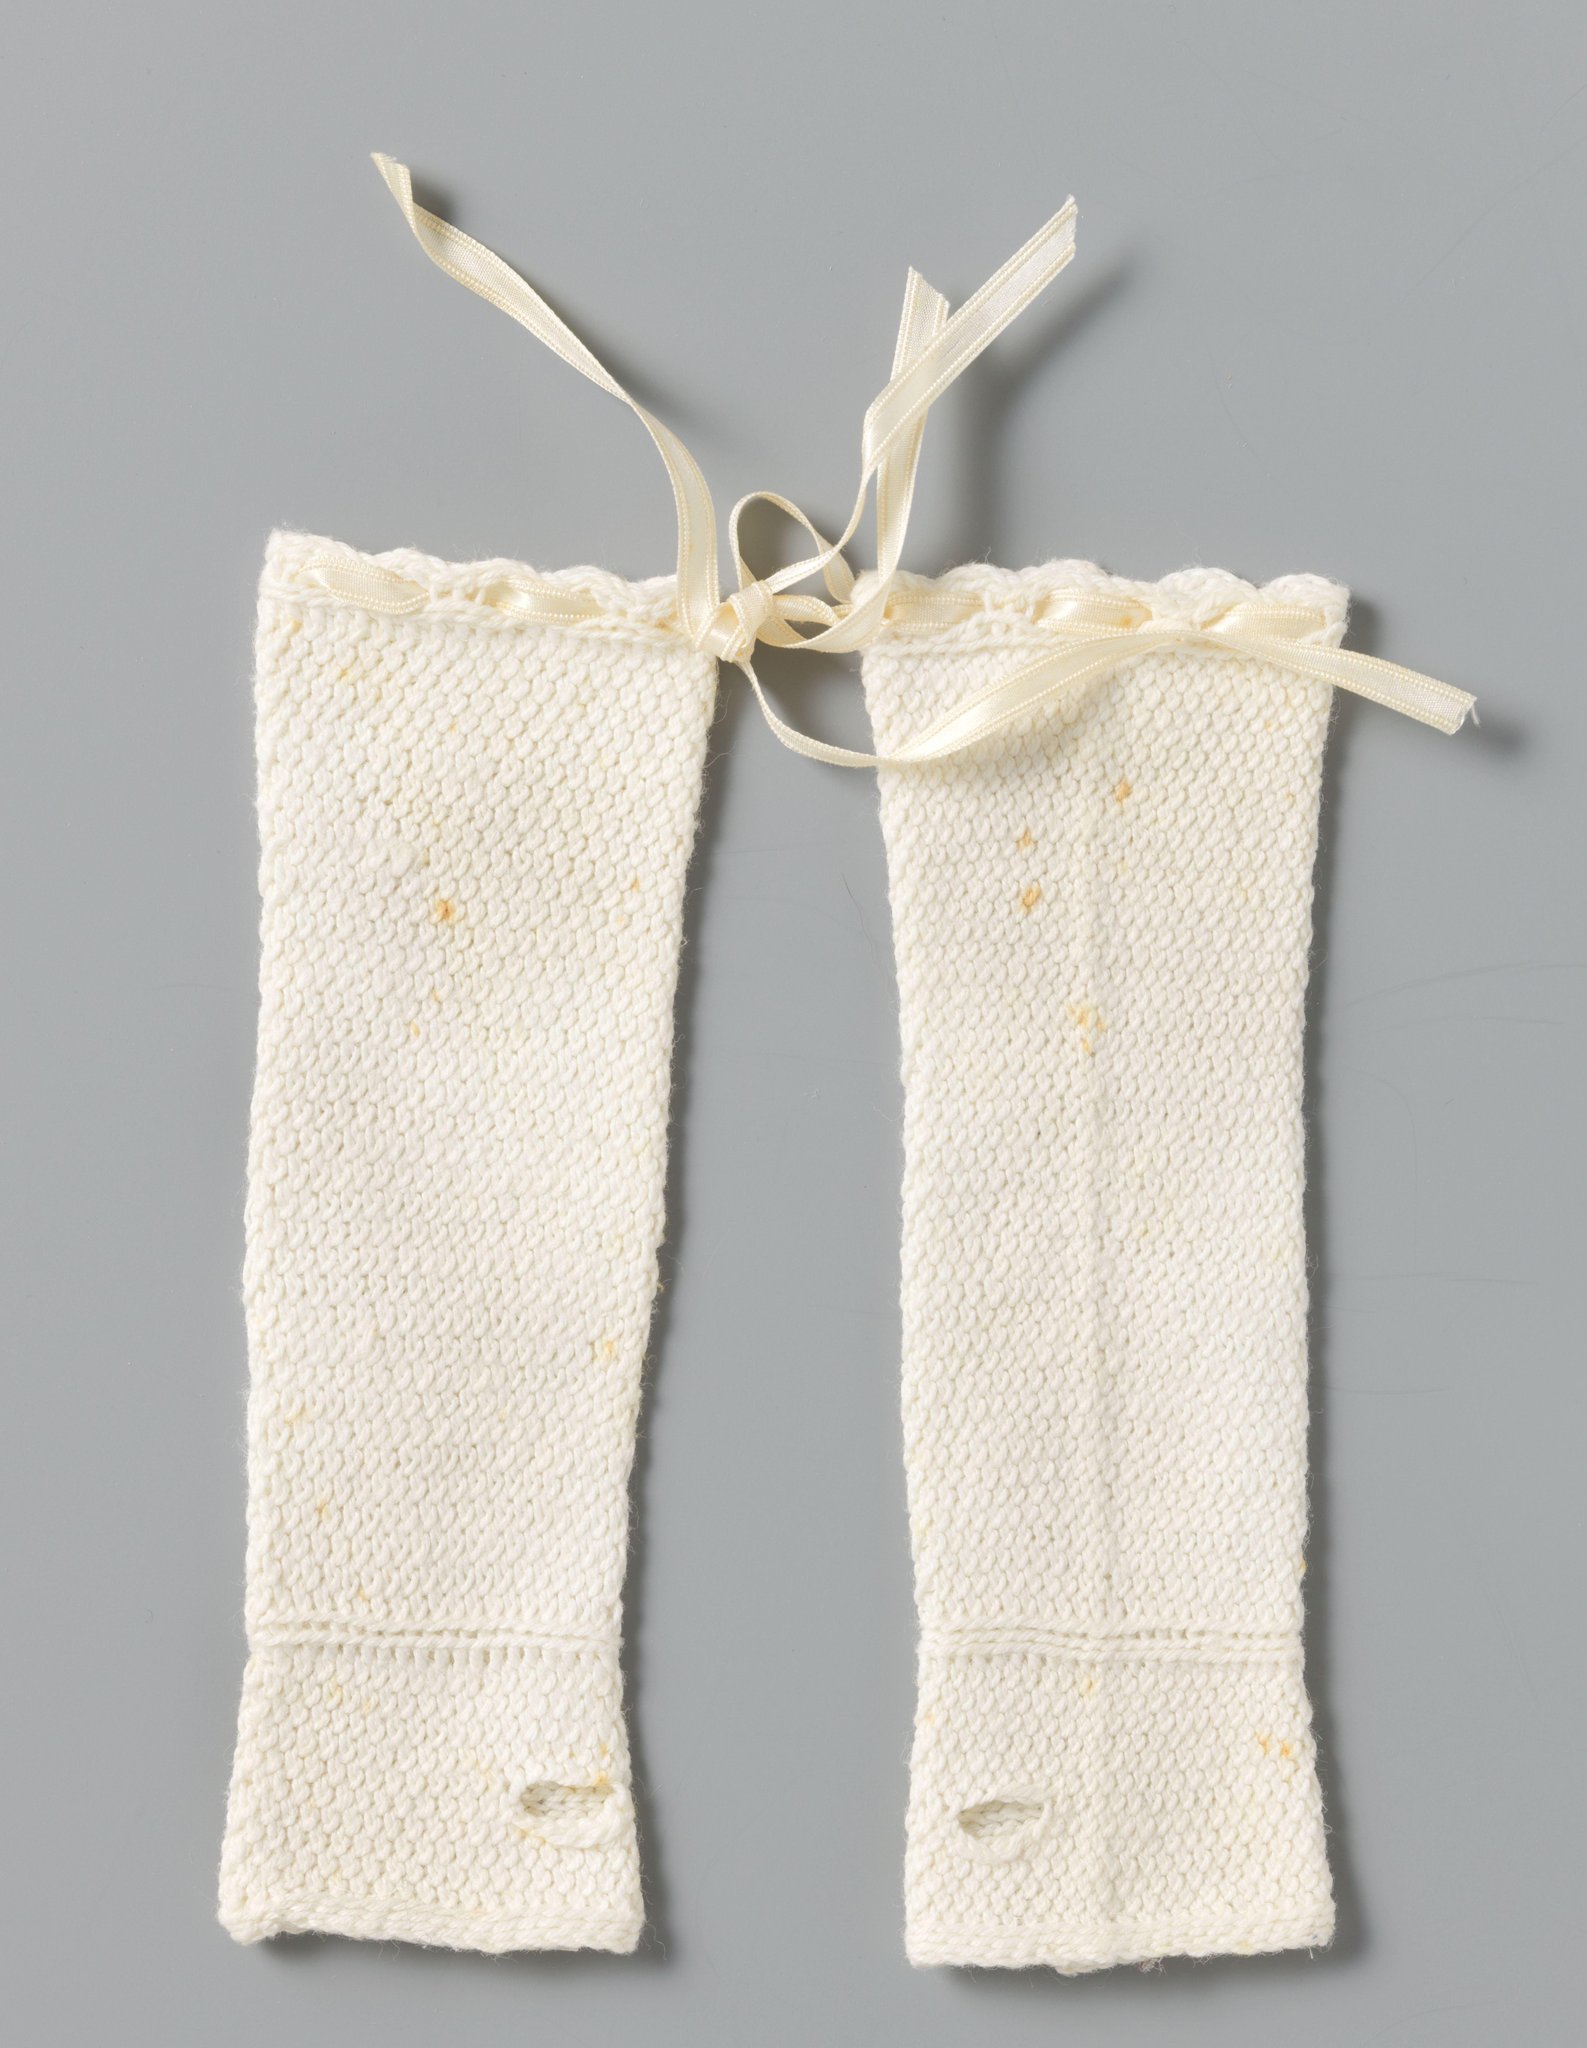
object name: mitt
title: Gebreide mitaine van witte katoen, met zijden doorrijgband en ribbelpatroon, voor baby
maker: Anonymous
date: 1880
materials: cotton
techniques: knitting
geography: europe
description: Gebreide mitaine van witte katoen, met zijden doorrijgband en ribbelpatroon, voor baby.